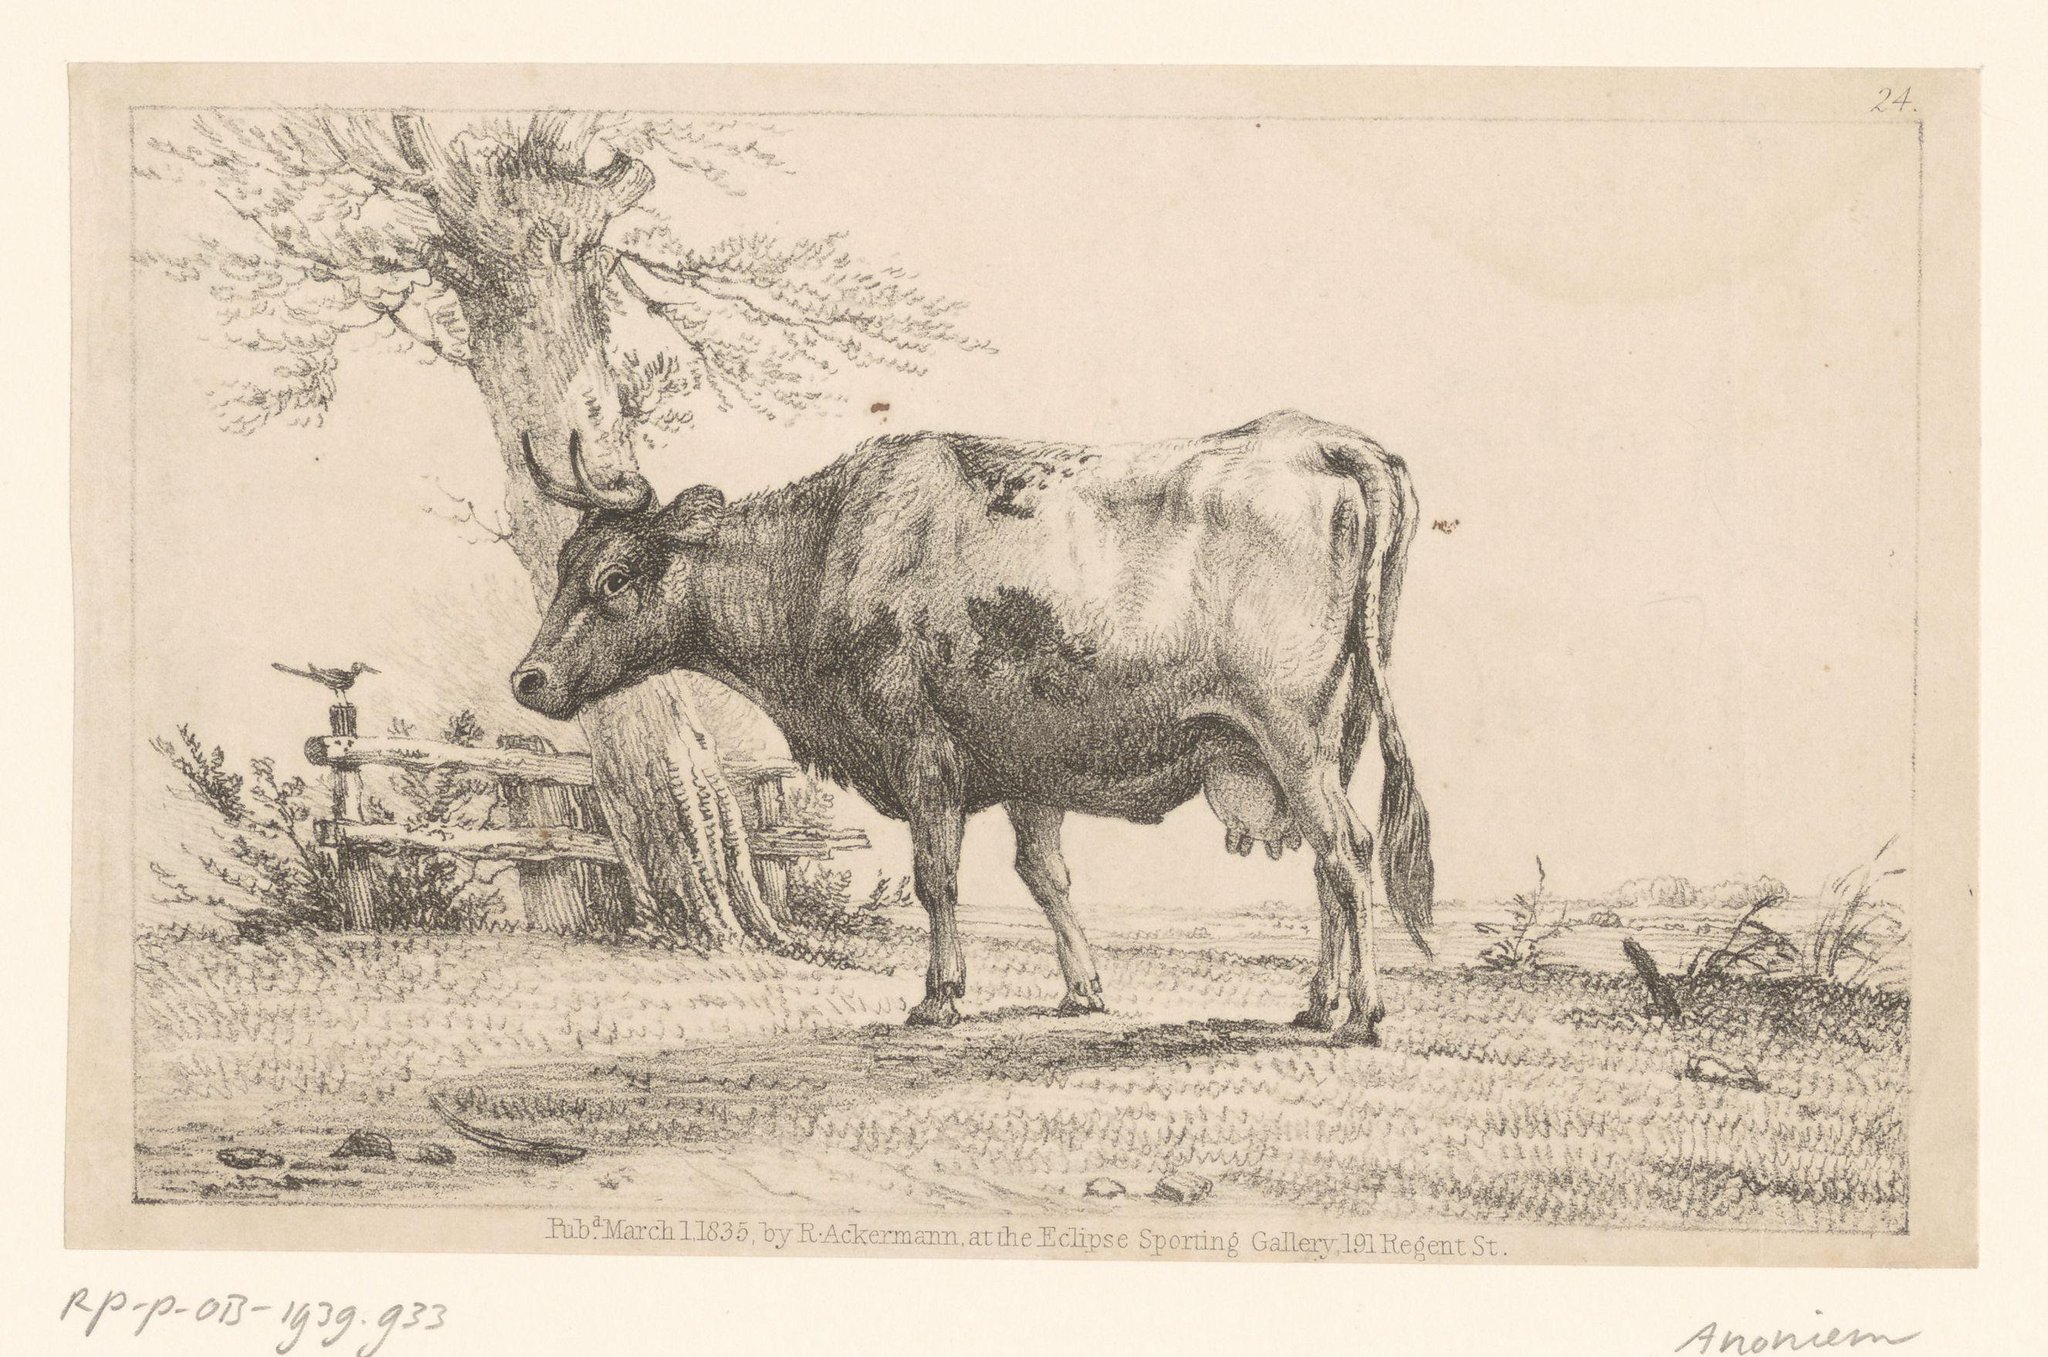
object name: print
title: Landschap met koe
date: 1835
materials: paper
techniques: lithograph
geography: london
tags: cow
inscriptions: collector's mark: Lugt 2166